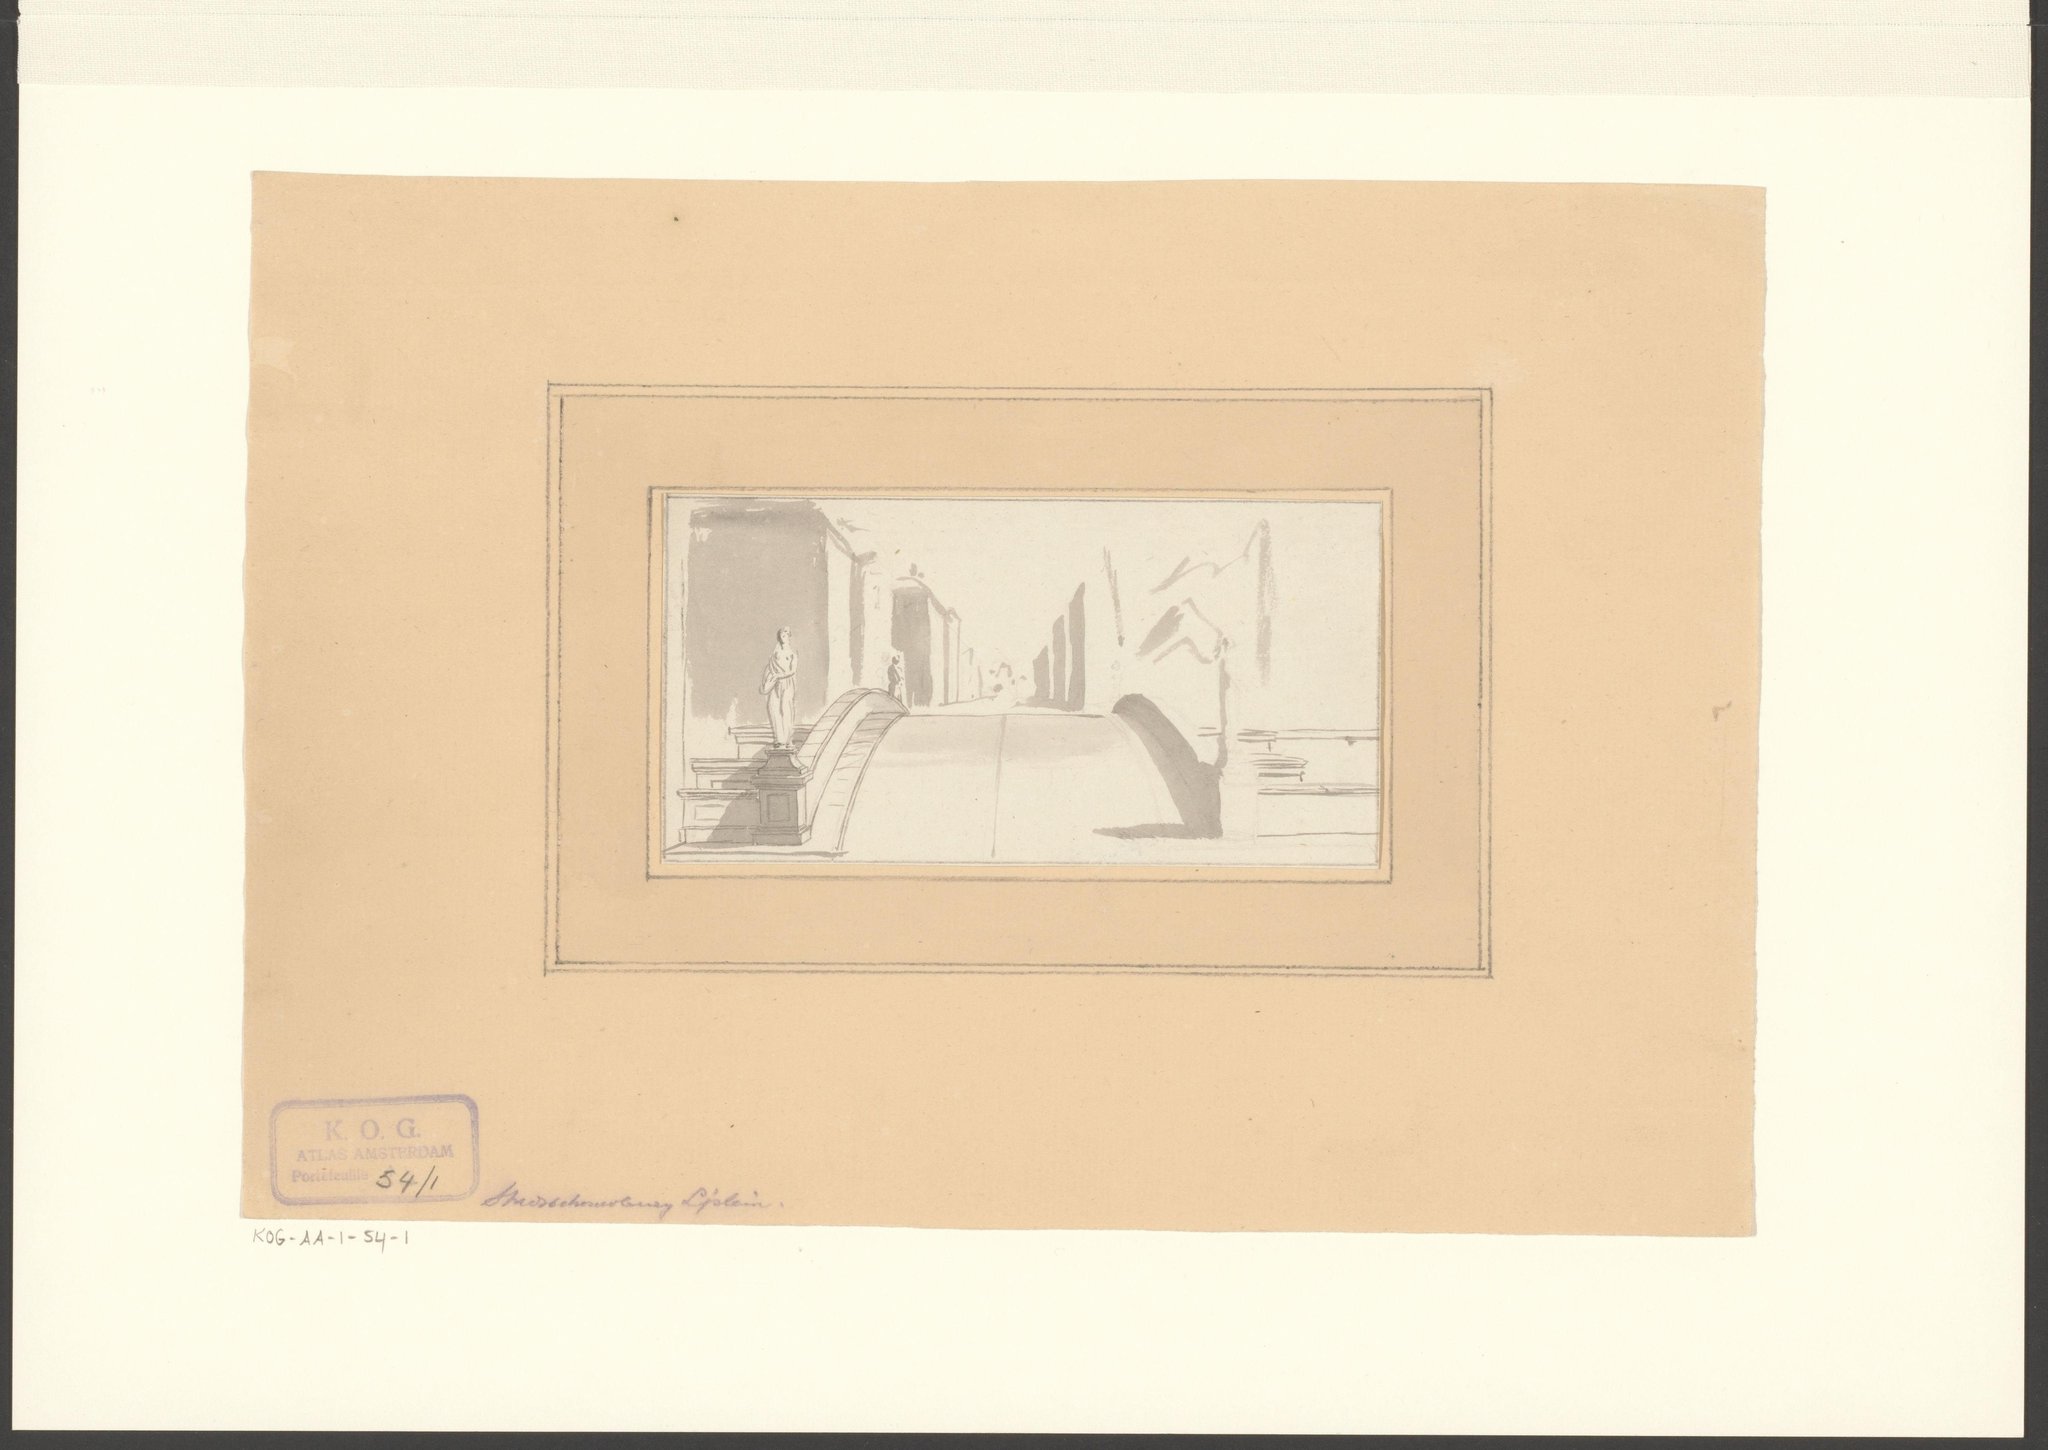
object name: drawing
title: Decorontwerp voor de Stadsschouwburg aan het Leidseplein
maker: Anonymous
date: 1850-1899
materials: ink, paper, pencil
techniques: brush, pen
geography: amsterdam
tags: set, scenery ~ stage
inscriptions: inscription: ‘Stadsschouwburg L'plein’, collector's mark: ‘54/1’ Lugt 1641b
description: Onderwerpsrubriek binnen de Atlas Amsterdam: Schouwburg Leidseplein tot 1874, toneelopvoeringen.